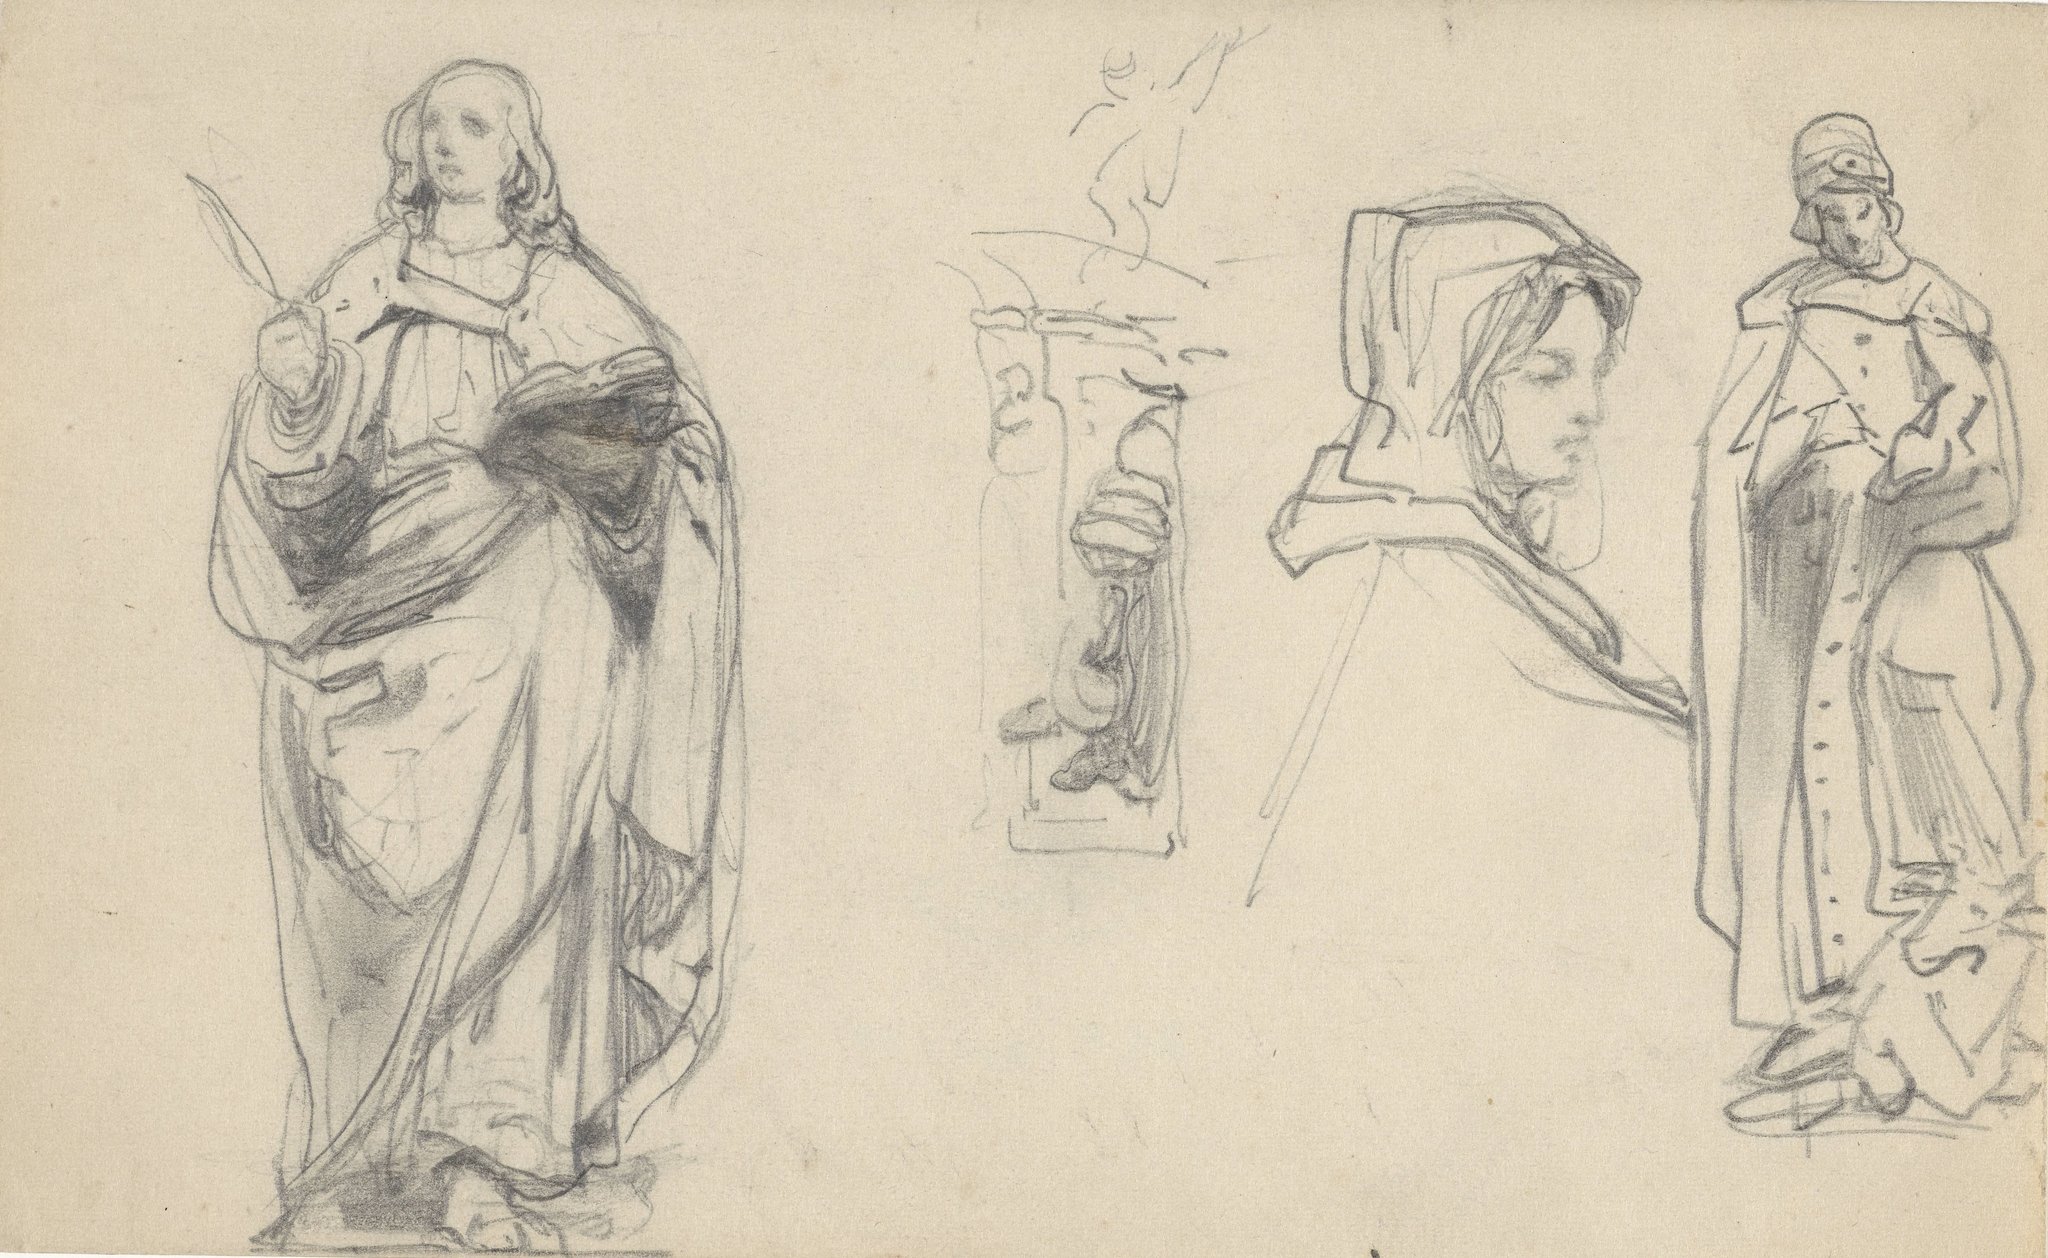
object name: schetsblad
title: Studies van vrouwen en een heiligenbeeld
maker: johannes bosboom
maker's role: draughtsman, painter, print maker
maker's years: 1817-1891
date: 1827-1891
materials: paper, pencil